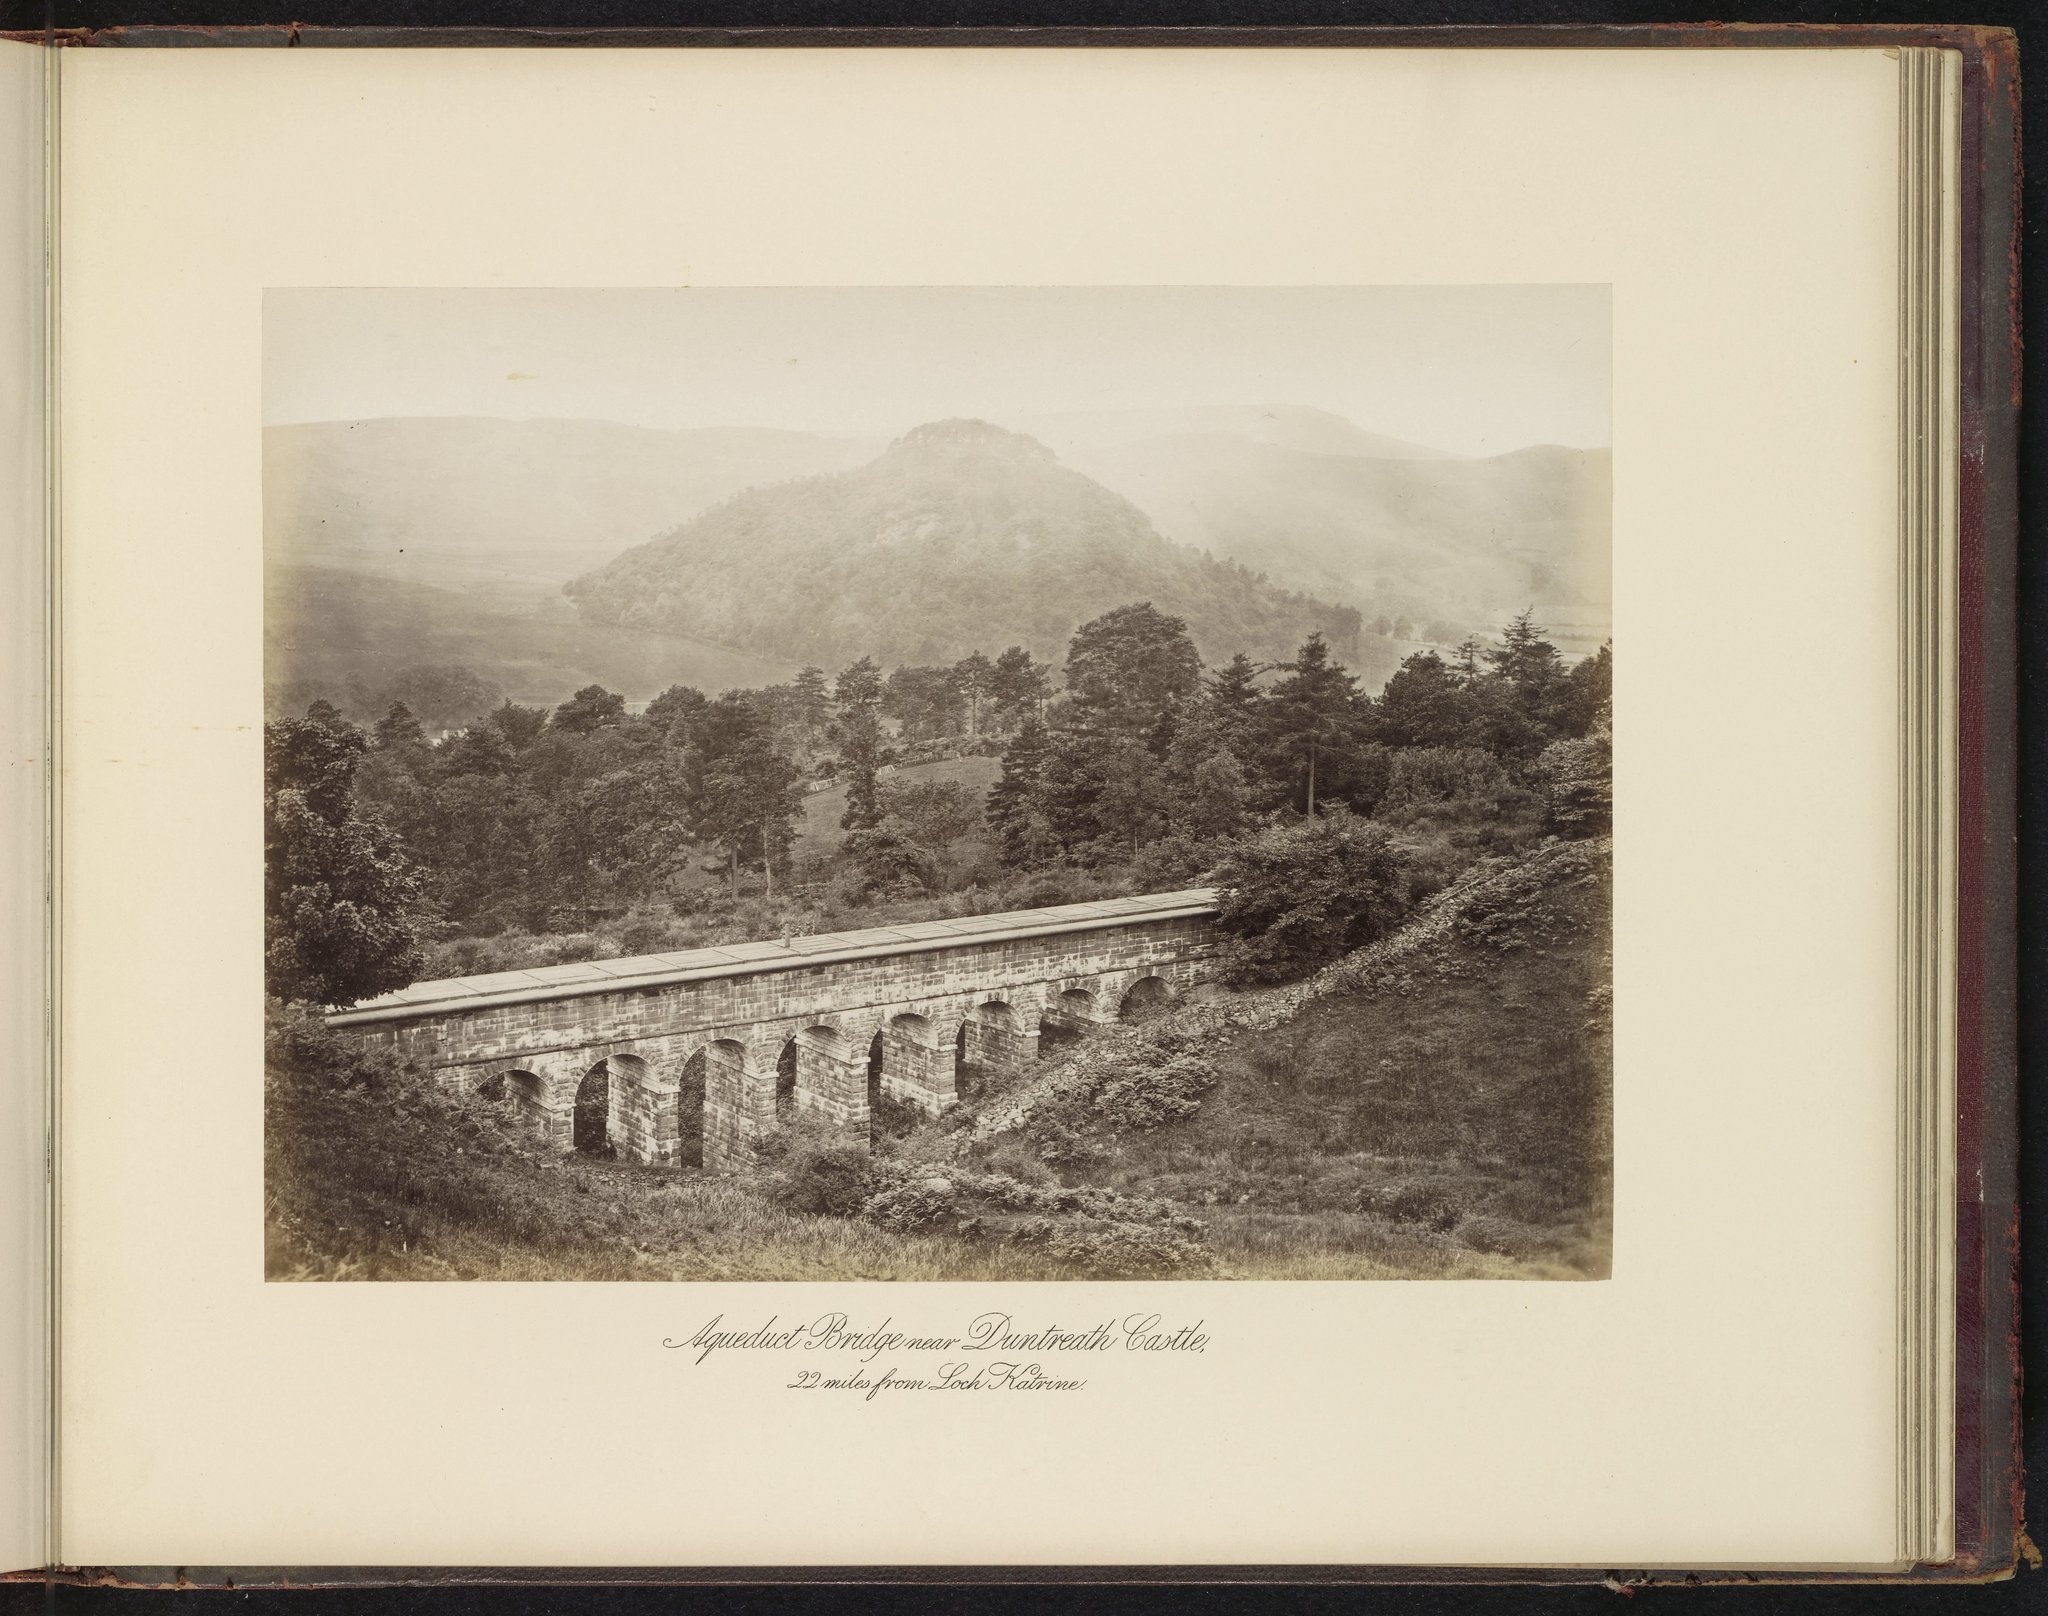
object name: photograph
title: Aqueduct Bridge near Duntreath Castle, 22 miles from Loch Katrine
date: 1879-1889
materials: photographic support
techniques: albumen print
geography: stirling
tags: dale, valley, aqueduct (~ water supply)